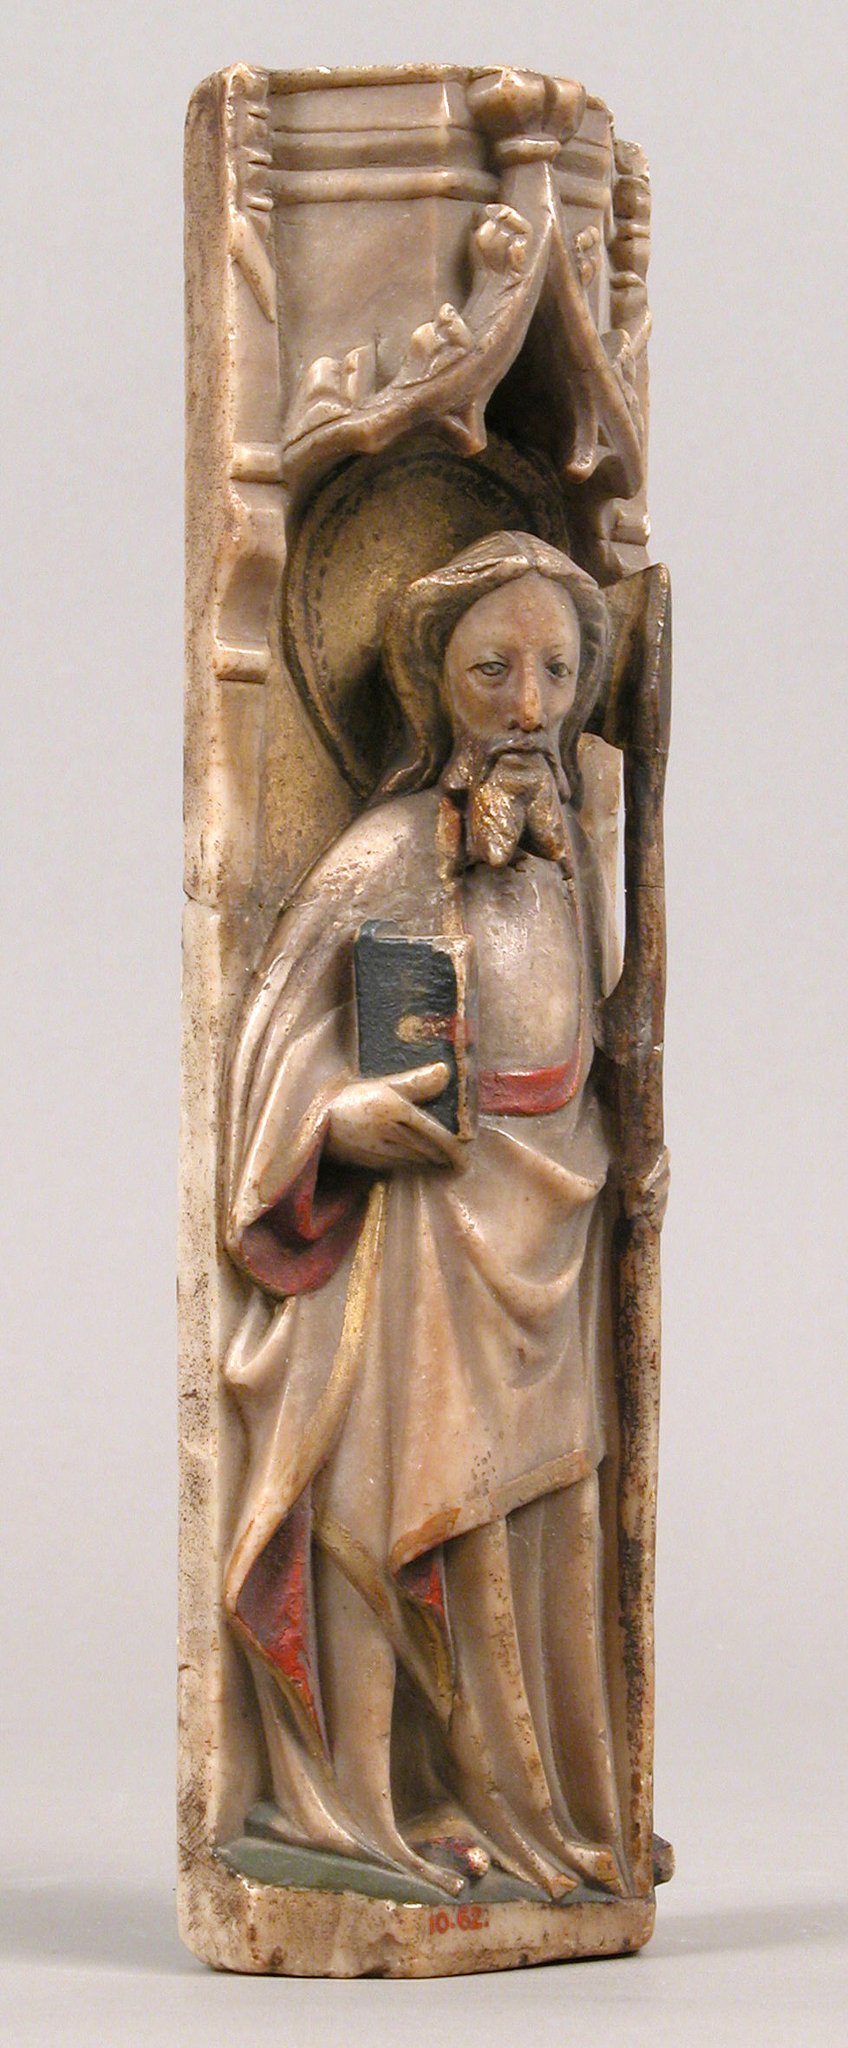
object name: relief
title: Relief of Saint Thomas under an ogee arch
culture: british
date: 1450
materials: alabaster, paint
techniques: gilding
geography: england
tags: saints